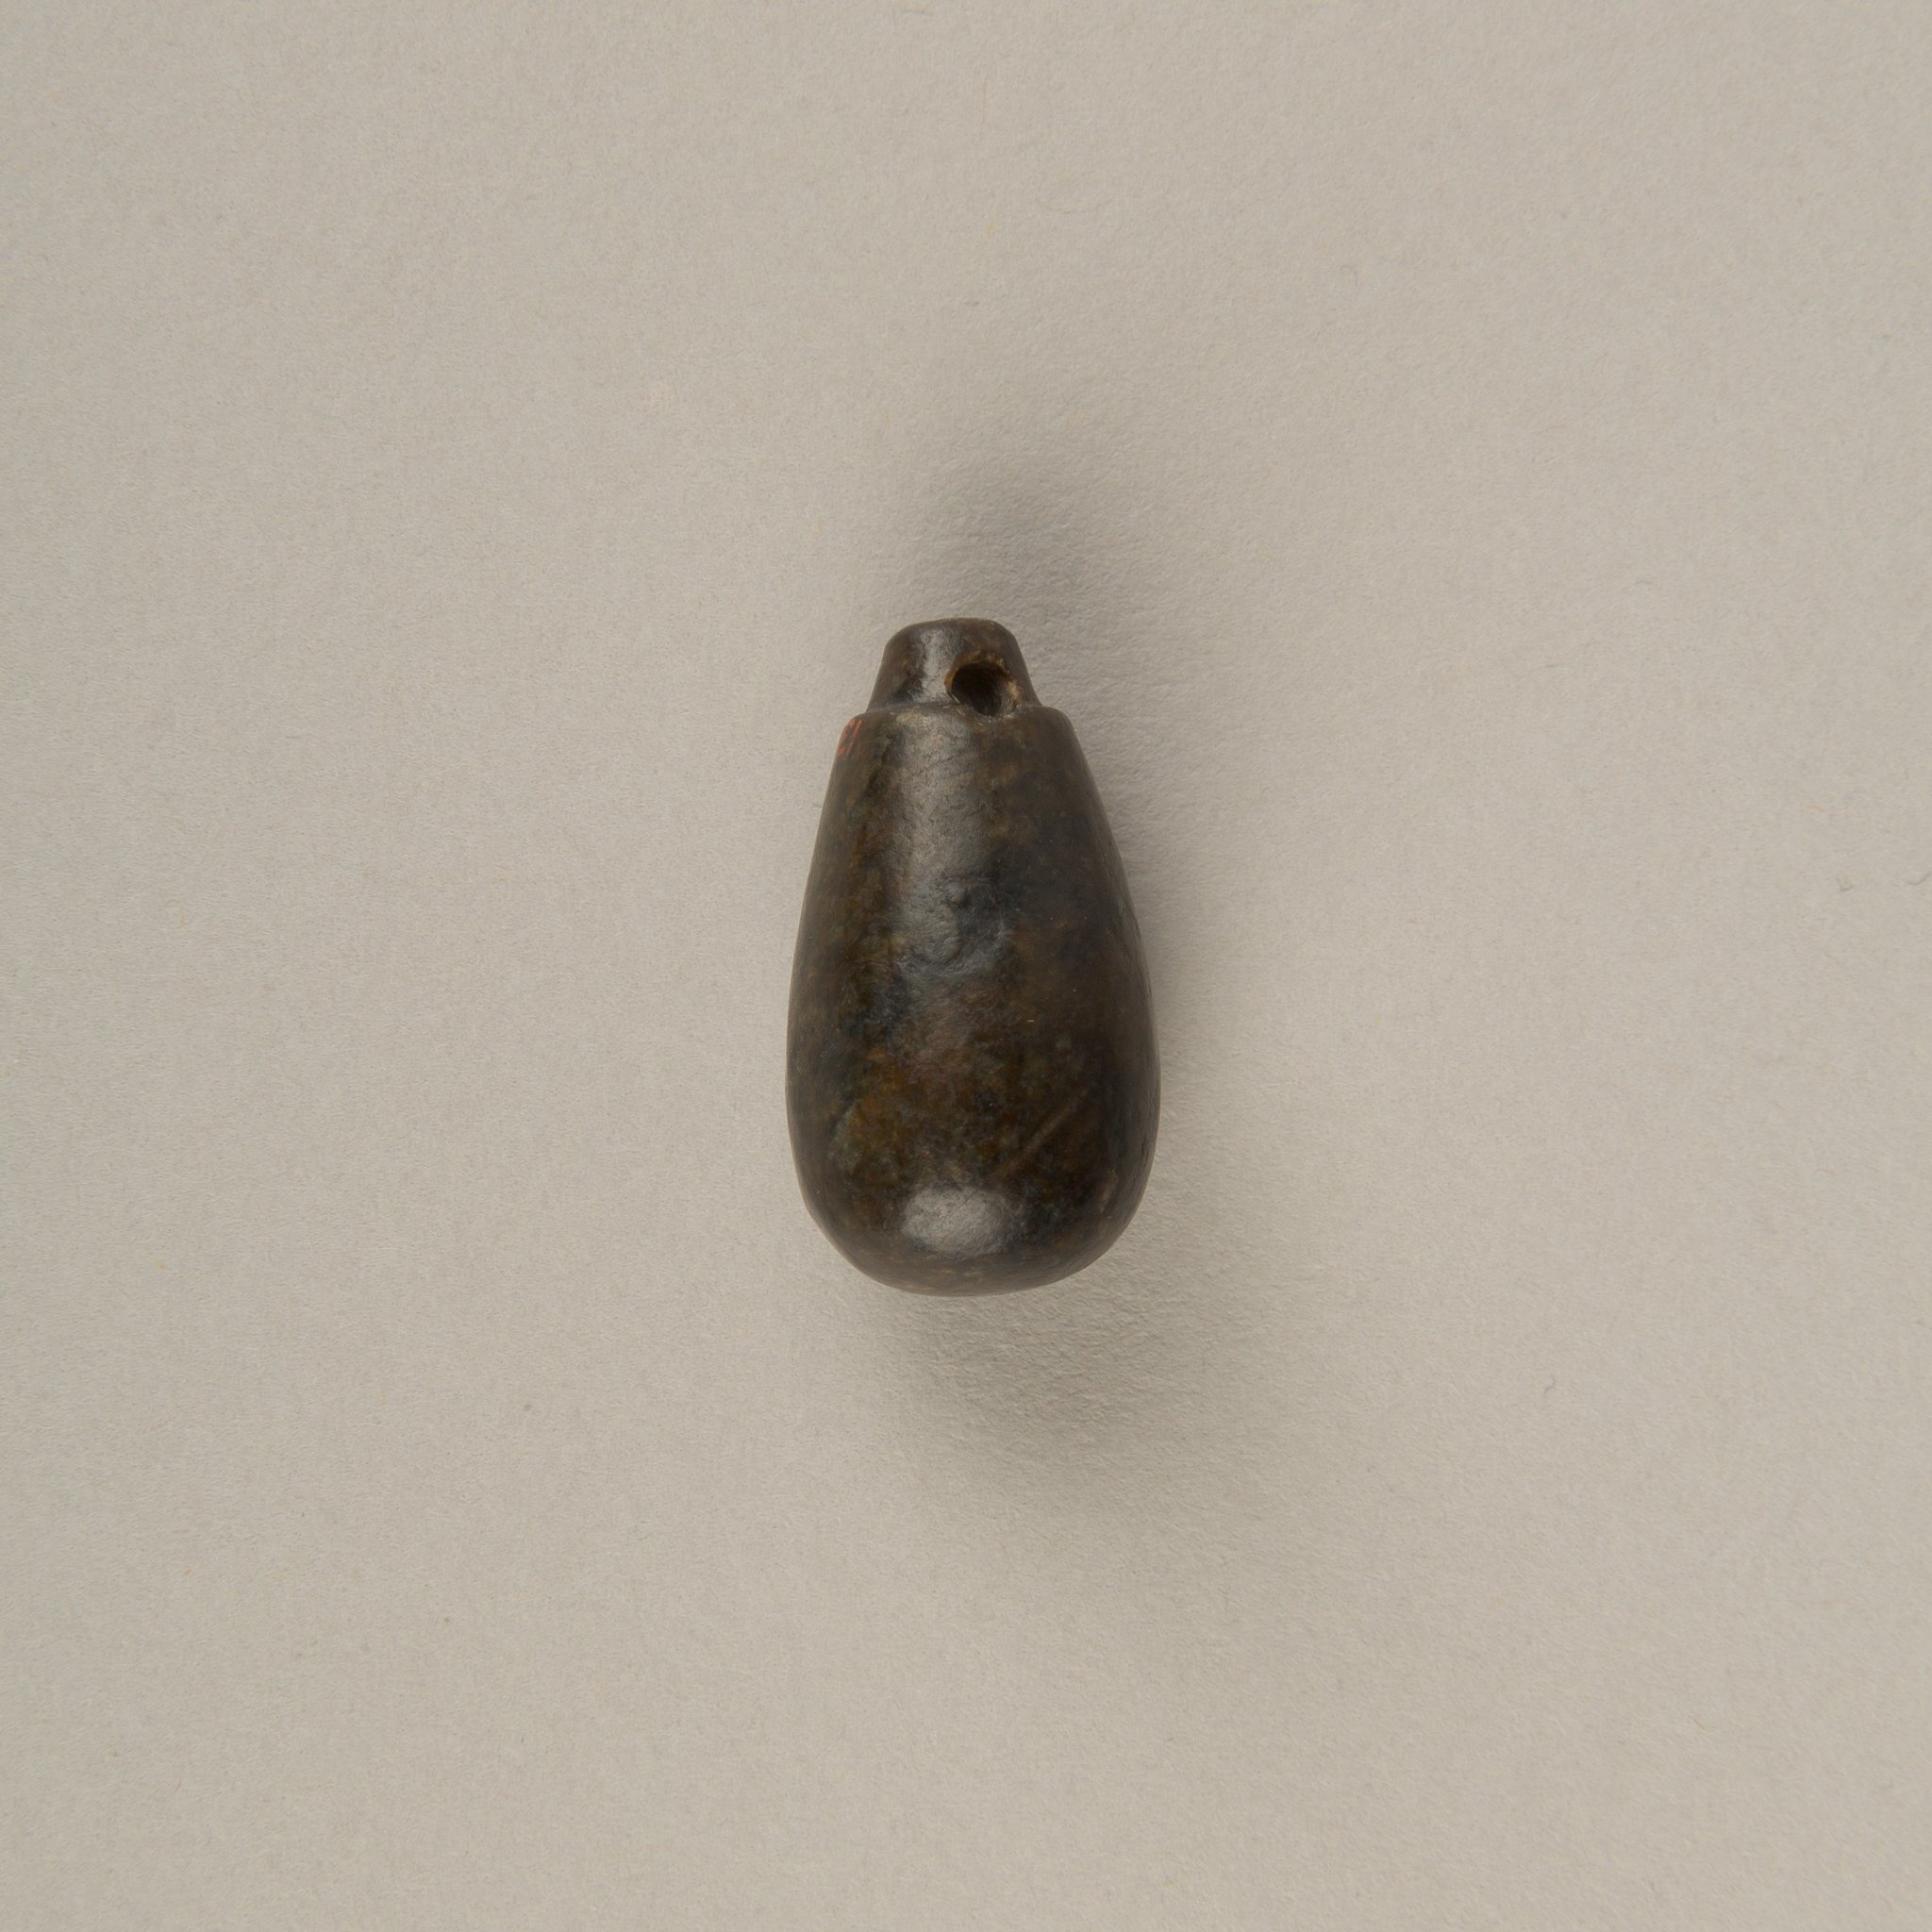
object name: earring or bonnet pendant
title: Earring or bonnet-pendant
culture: chinese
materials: jade